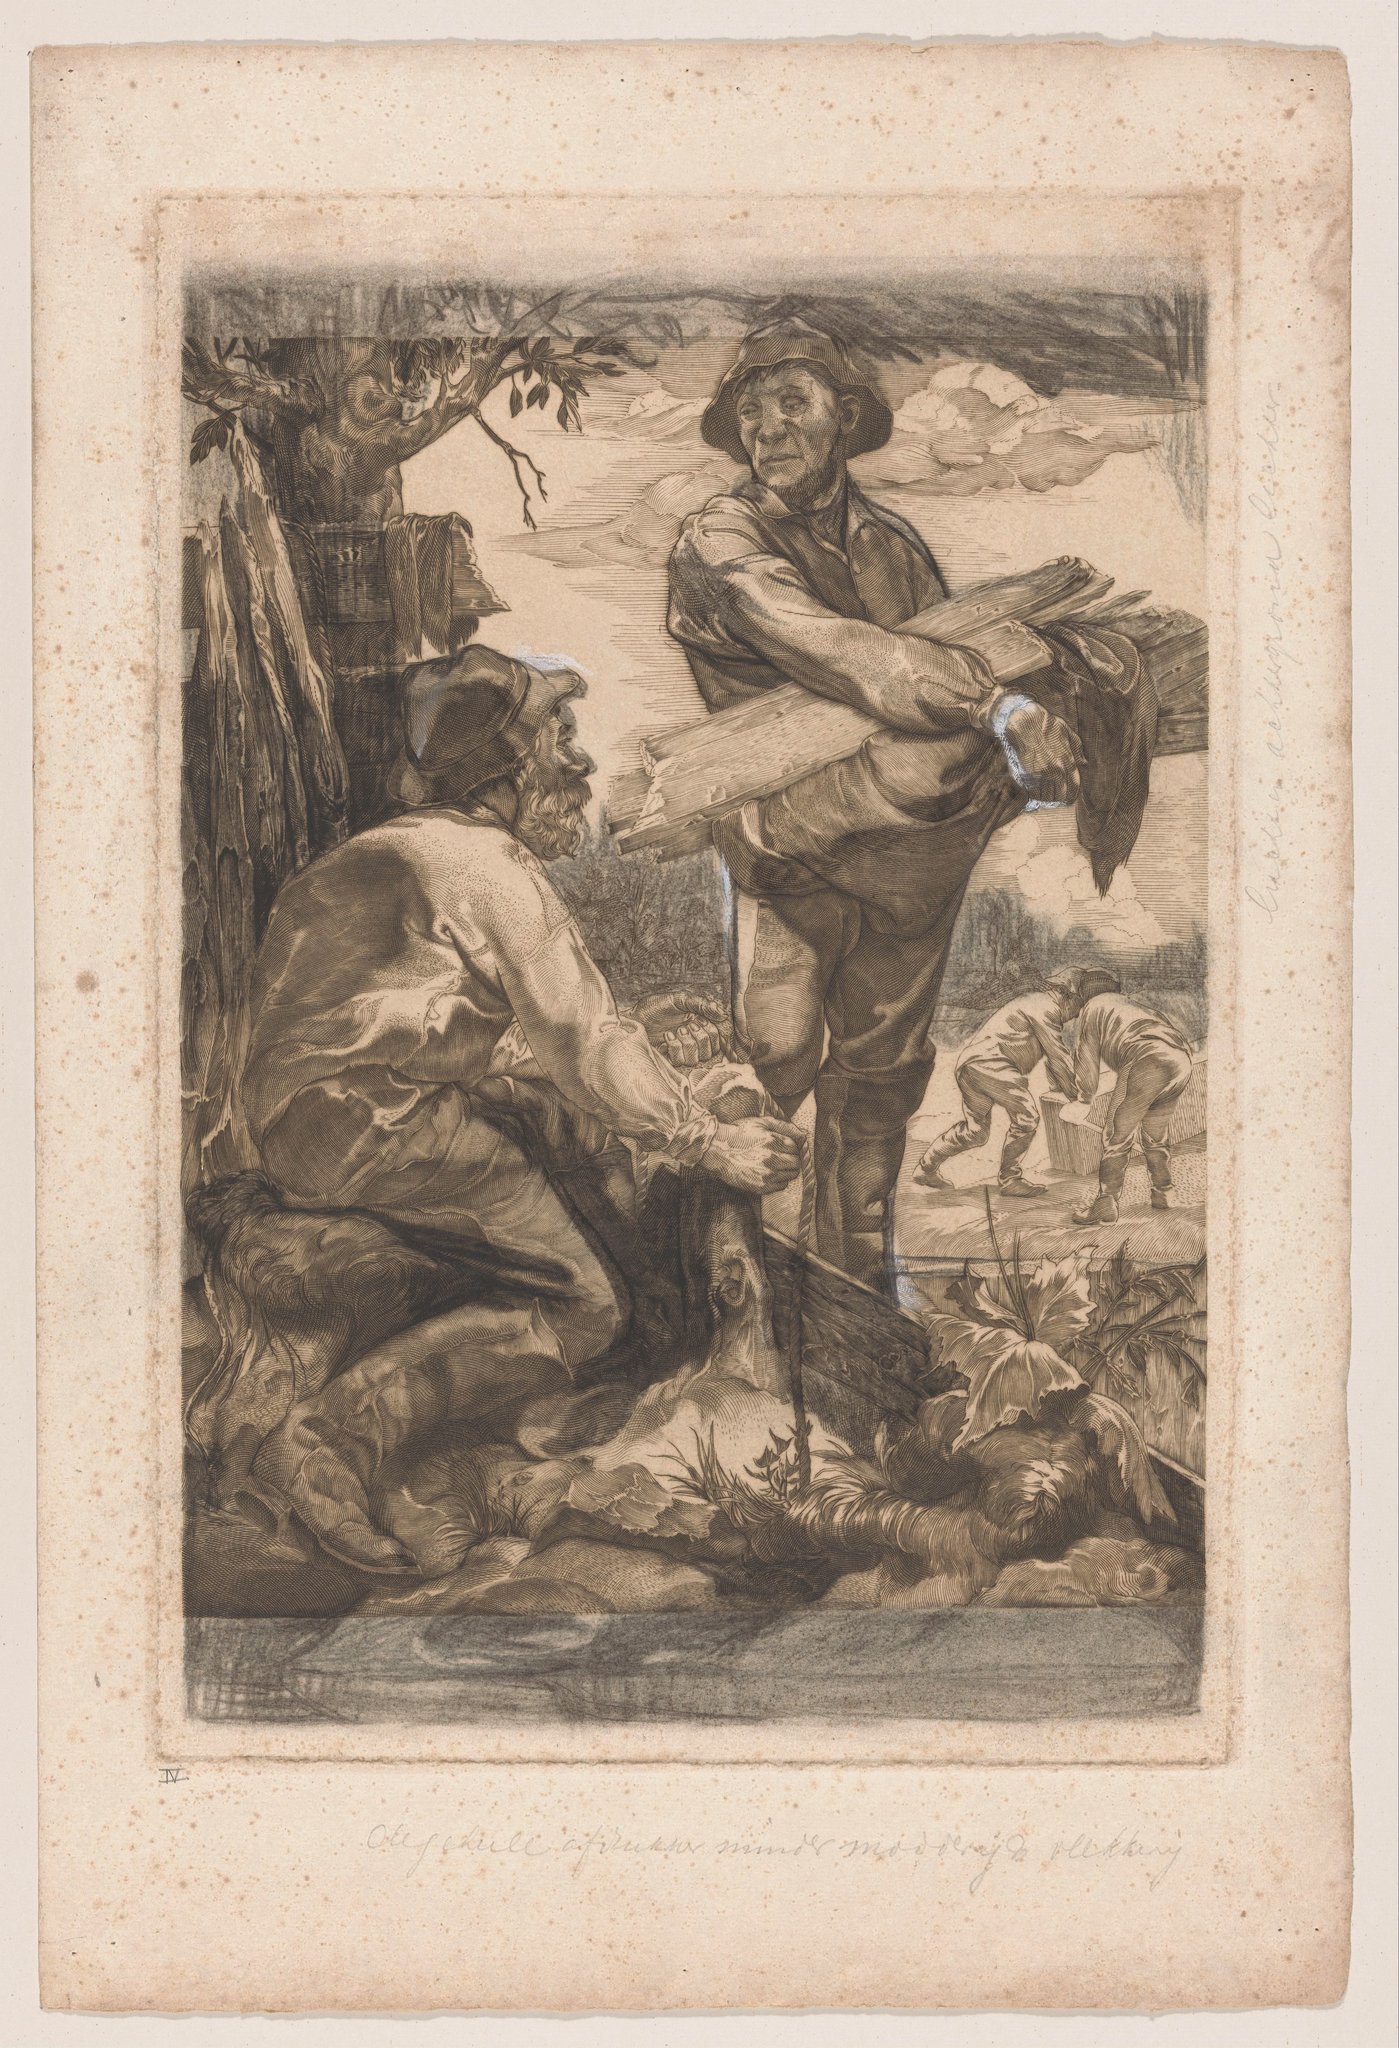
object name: print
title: Twee arbeiders met touw en planken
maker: johannes josephus aarts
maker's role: draughtsman, print maker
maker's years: 1871-1934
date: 1881-1934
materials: chalk, paper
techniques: engraving, intaglio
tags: plank, board ~ building material, working class, labourers, tools, aids, implements ~ crafts and industries: rope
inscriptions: collector's mark: Lugt 2166, annotation: ‘De gehele afdruk minder modderig en vlekkerig. Lucht en achtergrond lichter.’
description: Twee arbeiders met hoed, waarvan één zittend en de ander staand. De zittende man bindt een touw om een boomstam. De staande man houdt een stapel afbraakhout vast. Op de achtergrond wrikken twee arbeiders met een staaf onder een rechthoekig object. De voorstelling op de gravure is boven en beneden met krijt uitgebreid.